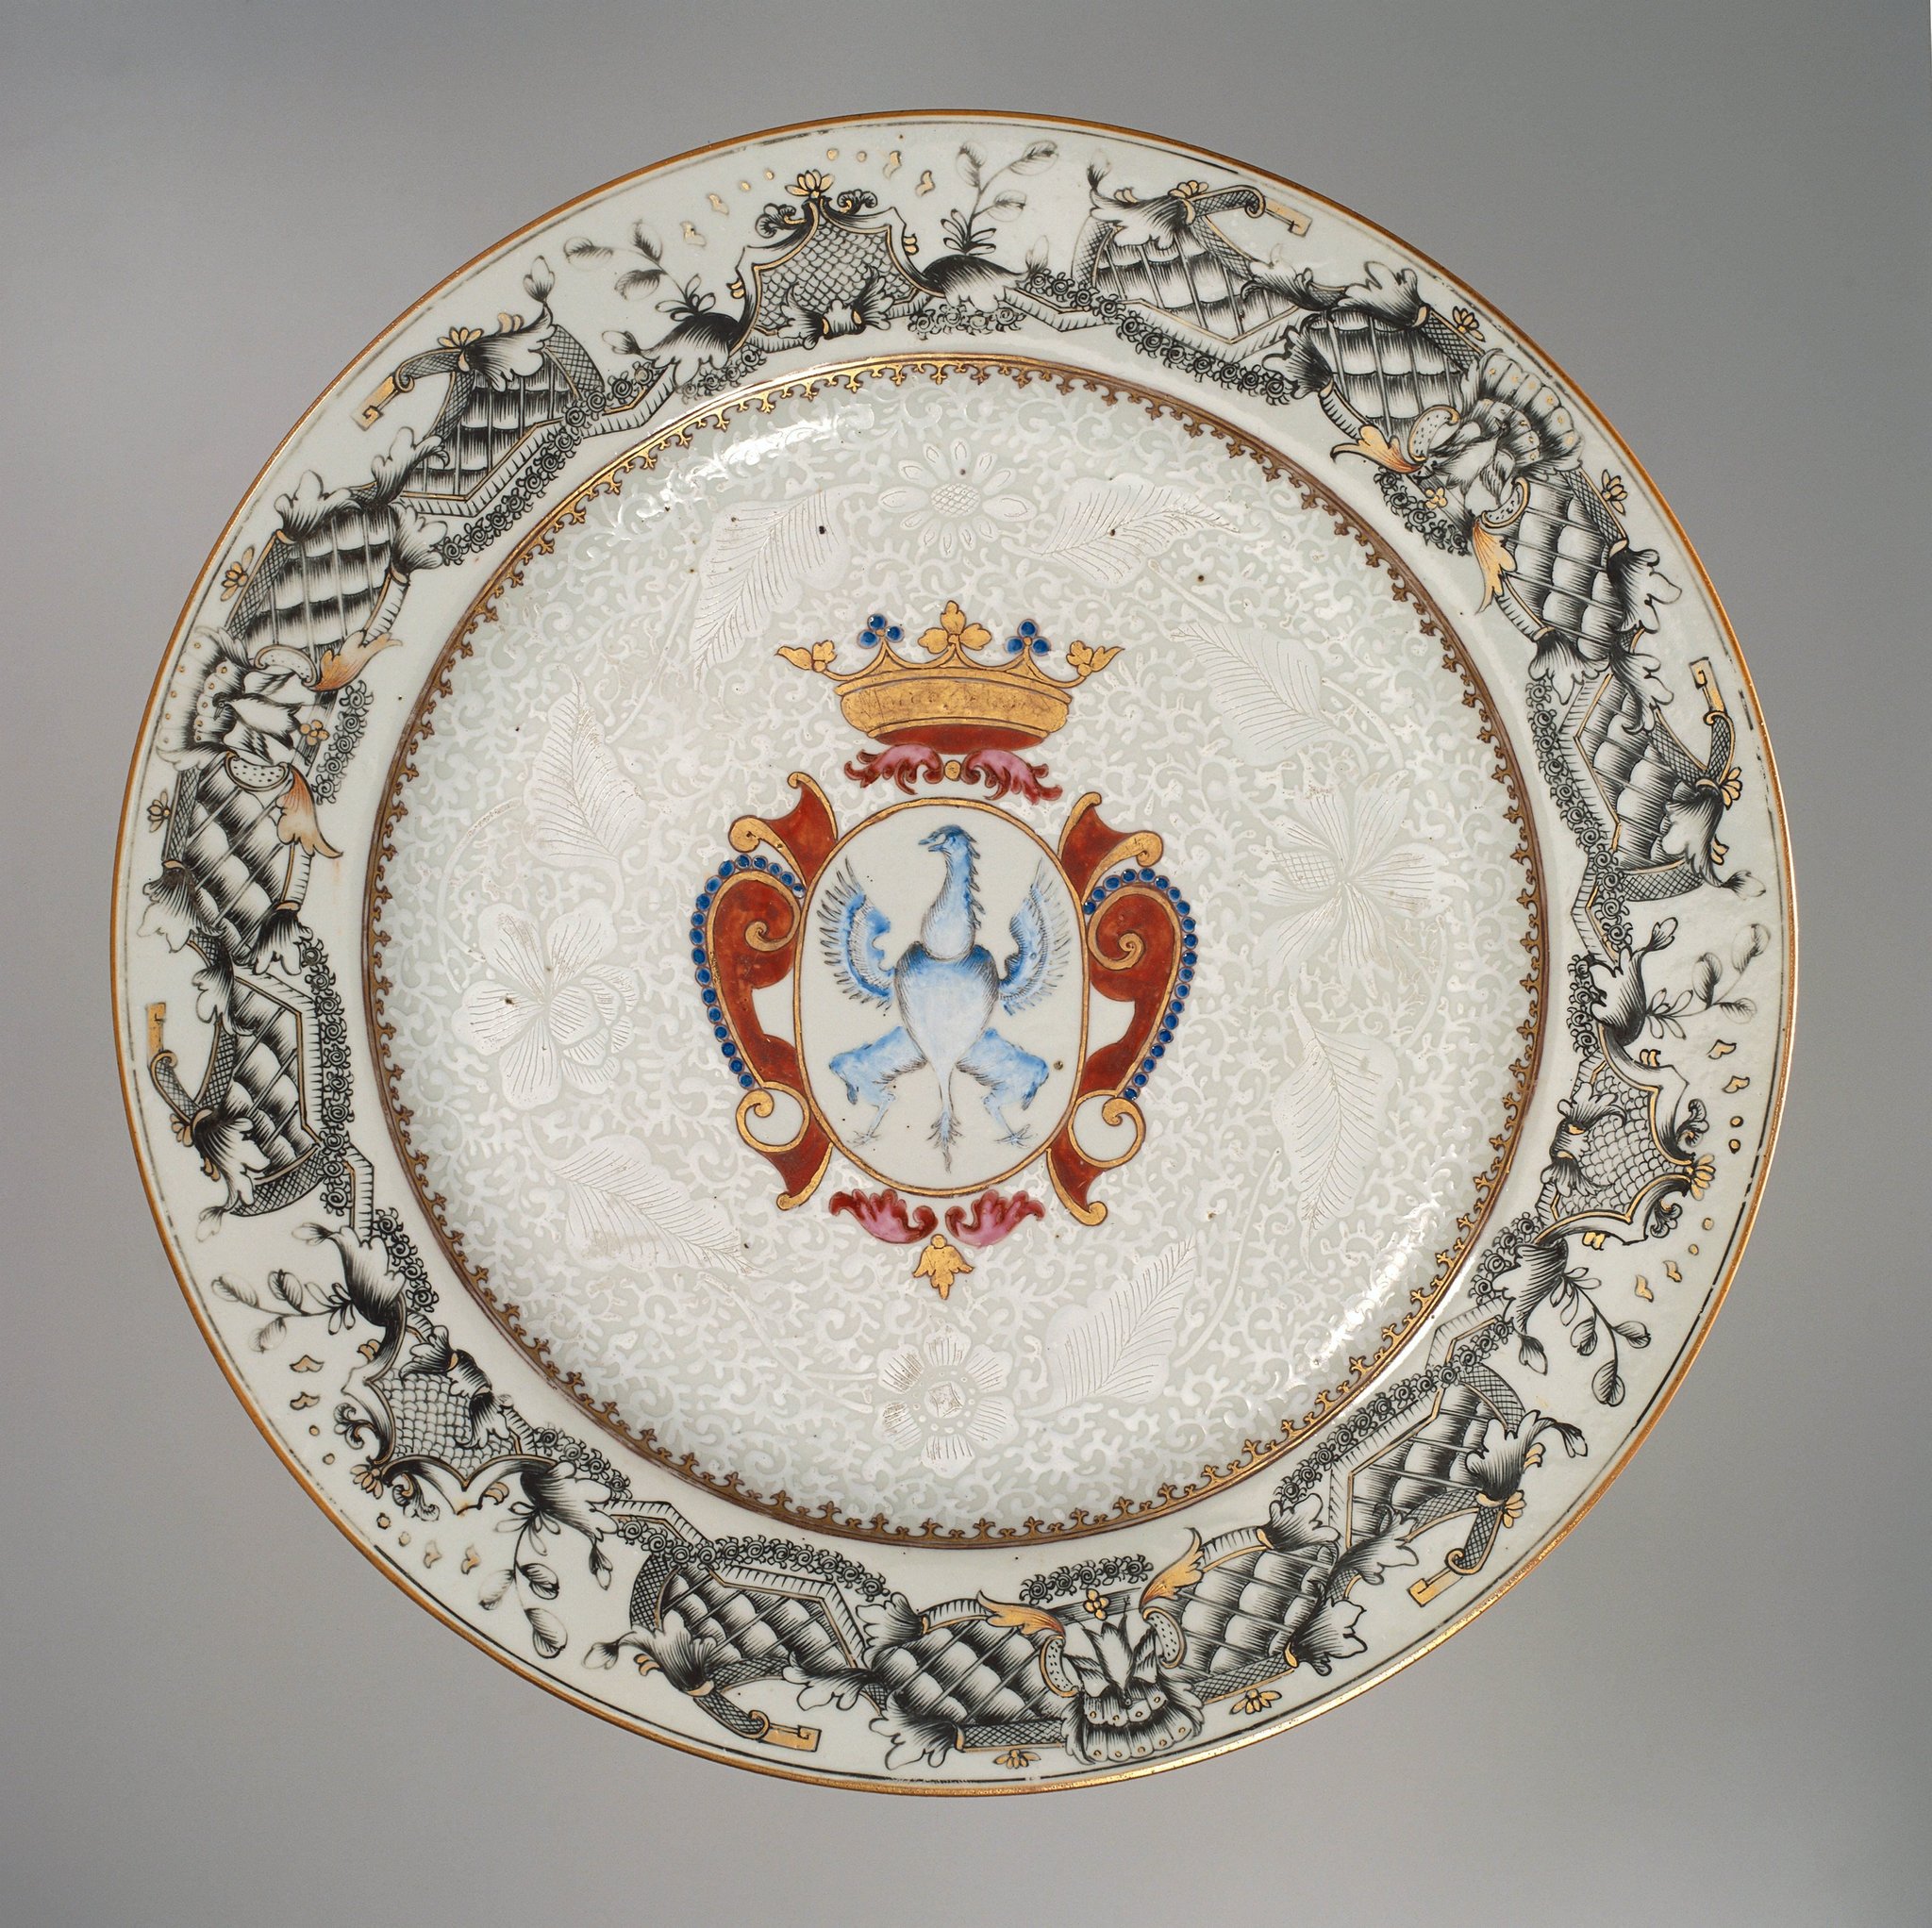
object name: platter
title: Dish with the arms of the Van der Broek of Dierkens family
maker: Anonymous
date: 1725-1749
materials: glaze, gold, paint, porcelain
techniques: firing, gilding, turning, vitrification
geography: china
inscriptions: label: ‘Hasselaer’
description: Schotel van porselein, beschilderd op het glazuur in blauw, rood, roze, zwart en goud. Op het plat het wapen van de familie Van den Broek of Dierkens. Op het ovale wapenschild staat een blauwe adelaar afgebeeld. Het helmteken is een gouden kroon en een dekleed in rood, goud en blauw in Louix XIV-stijl. In het plat een patroon van bloemen en ranken in bianco-sopra-bianco. Op de wand een speahead-border. Op de rand een versiering in de Weense Du Paquier-stijl met cartouches in een geometrisch patroon, bloemen, guirlandes en pauwen. Oud label op de onderzijde met 'Hasselaer'. Wapenporselein met emailkleuren.